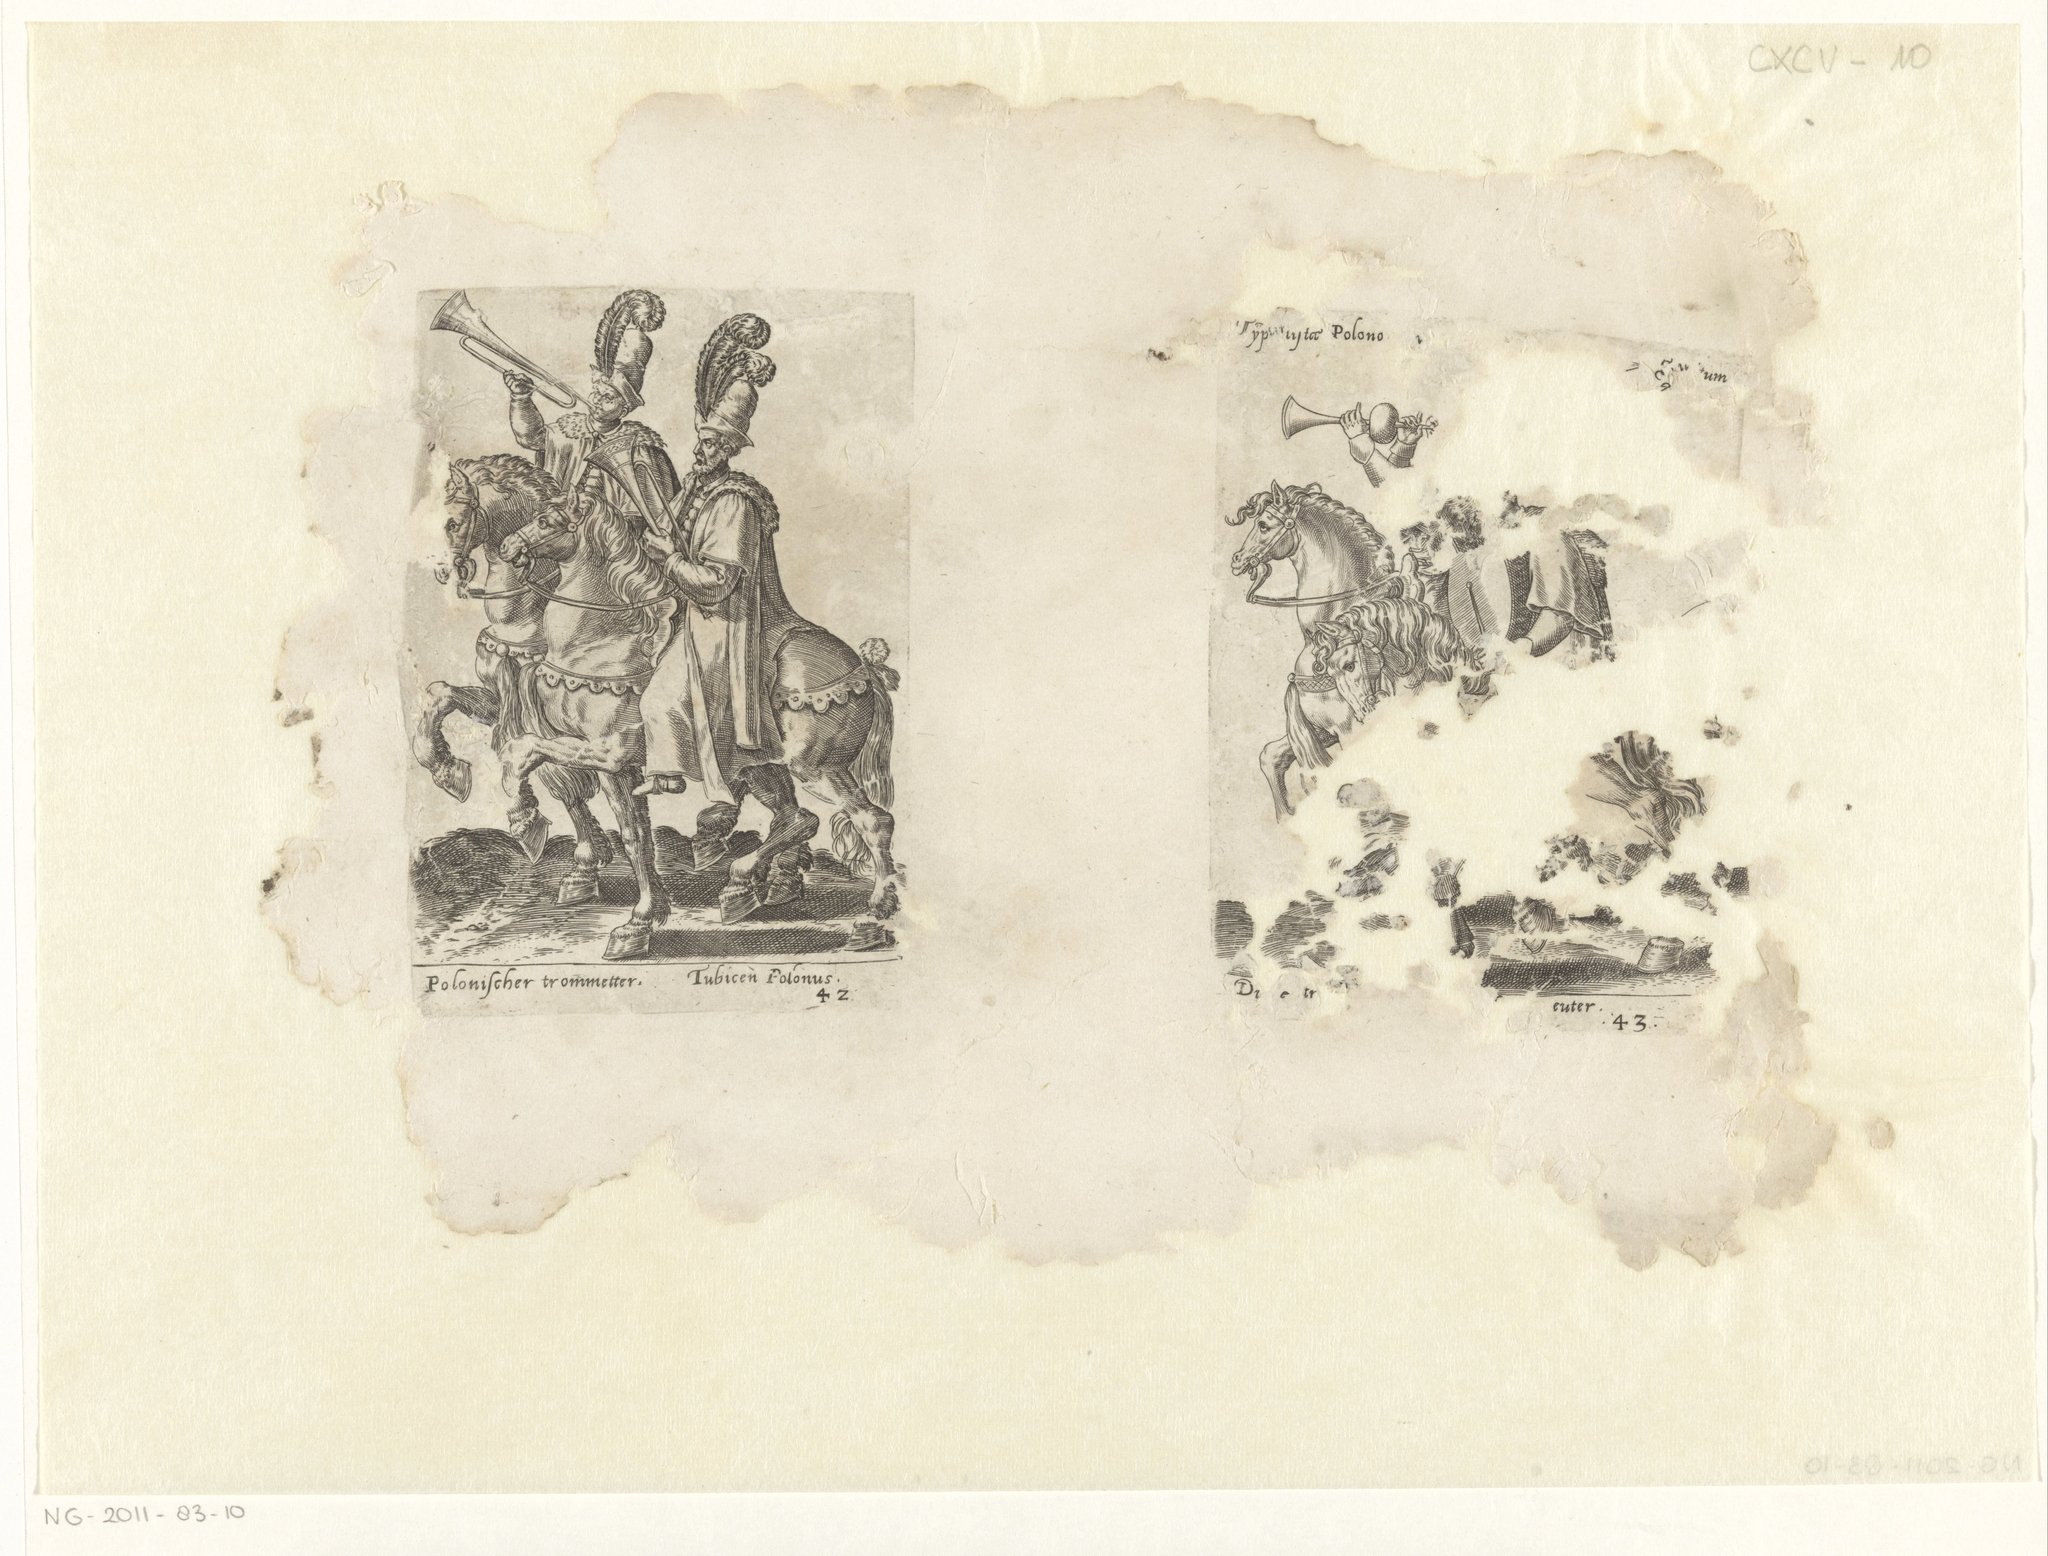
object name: print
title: Ruiterserie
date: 1576-1596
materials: paper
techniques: engraving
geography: cologne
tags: warfare; military affairs (+ cavalry, horsemen), folk costume, regional costume, military clothing and other equipment (uniforms, cap, armour, helmet, etc.)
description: Prent 42 en 43 uit een serie van 77, mogelijke serietitel Diversarum gentium armatura Equestris. Latere editie van serie Equitum Descripcio, Quomodo Equestres (...). De prenten in de Nova Zembla collectie zijn tijdens een expeditie van Willem Barendsz en Jacob van Heemskerk in 1596-1597 noodgedwongen in het winterkamp, het ‘Behouden Huis’, op het eiland achtergelaten. De prenten waren in één of meerdere stapels als handelswaar meegenomen vanuit Amsterdam. Bijna drie eeuwen later, in 1871, keerde de Noor Elling Carlsen terug naar Nova Zembla en vond daar de restanten van het ‘Behouden Huis, inclusief een groot deel van de inventaris. Een deel van de prenten, in de vorm van aaneengekoekte kluiten, werd toen ook teruggevonden. De papierkluiten waren soms op meerdere plekken gebroken. Tussen 1975-1979 zijn de prenten van elkaar gescheiden. Dit leverde in totaal ca. 1000 fragmenten van ca. 400 afdrukken van ca. 150 verschillende prenten op. Voor zover mogelijk zijn de fragmenten samengevoegd en zijn de prenten gereconstrueerd.